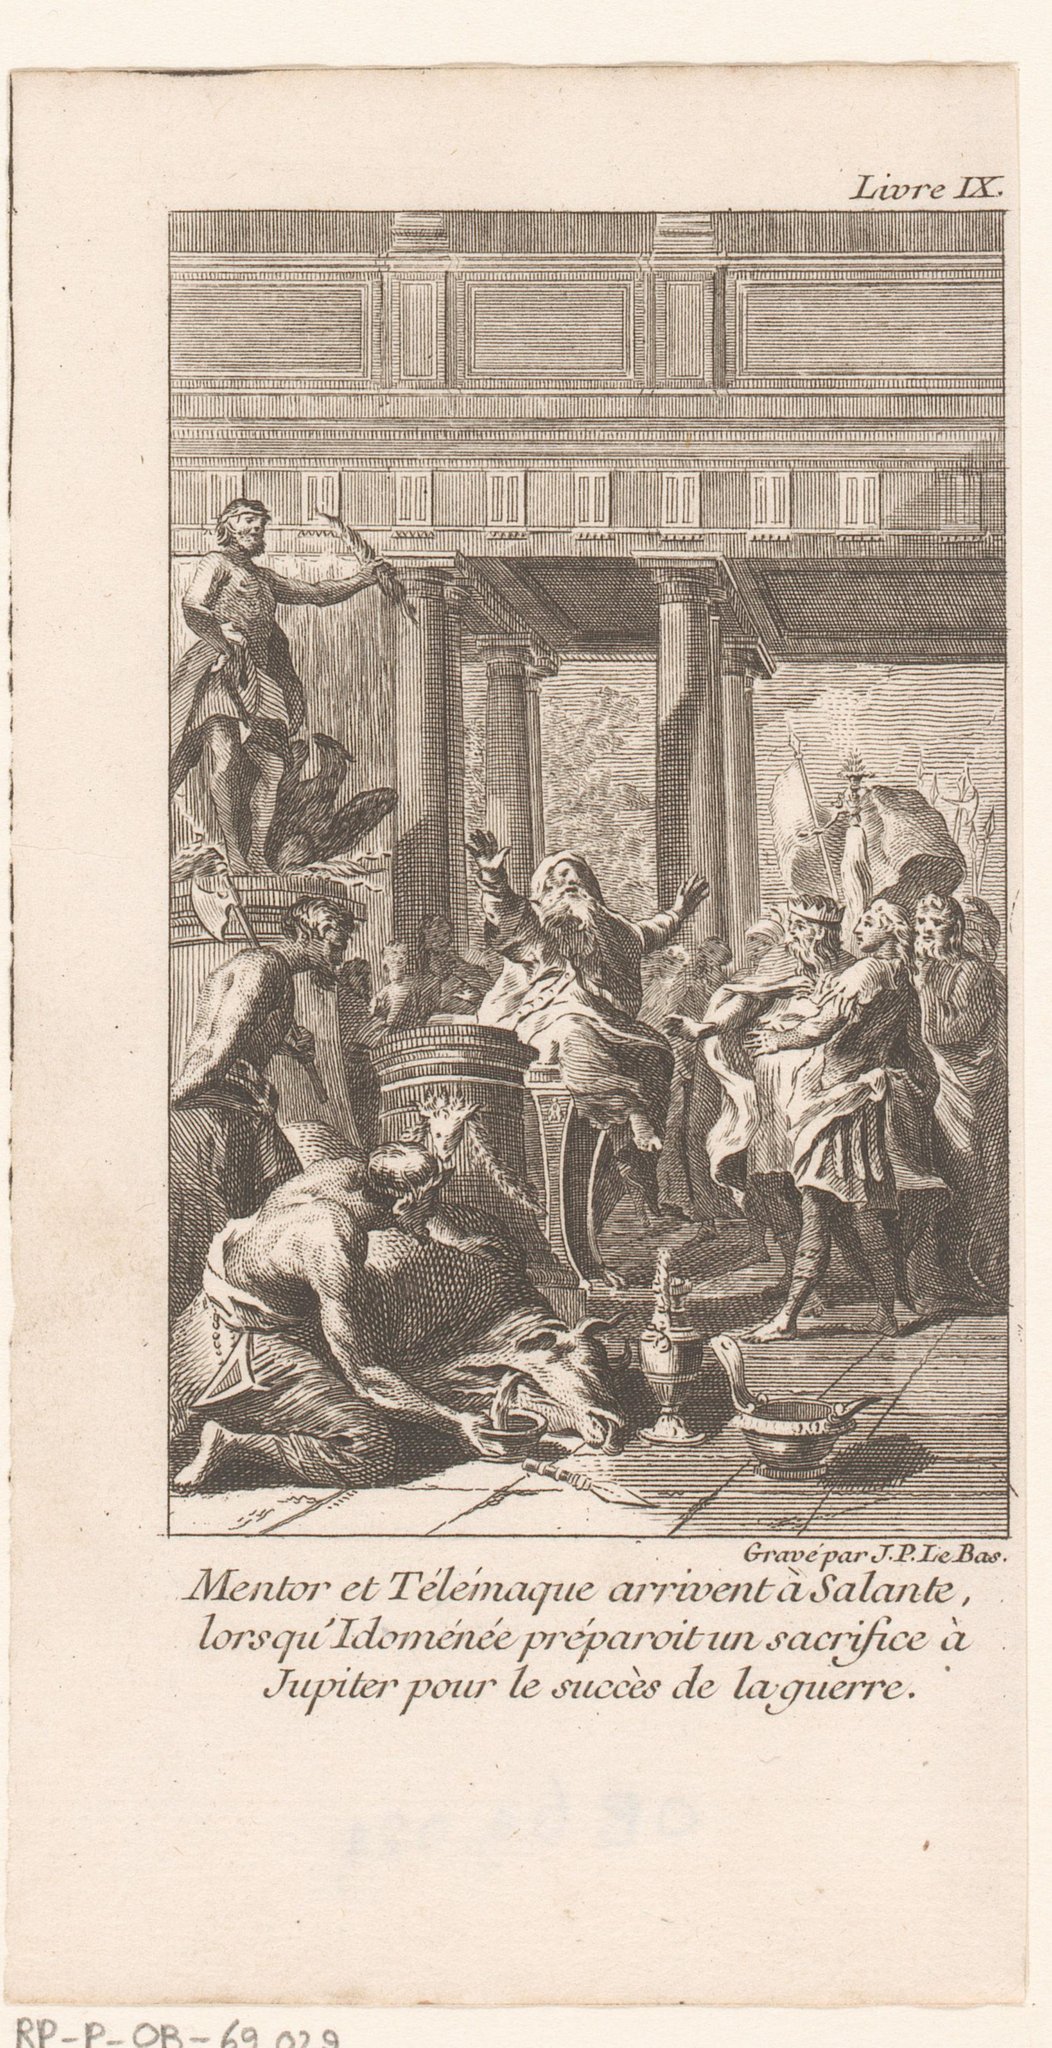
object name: print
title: Mentor en Telemachus arriveren op Salento bij Idomeneus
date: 1755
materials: paper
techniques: etching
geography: paris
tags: (fenelon, telemachus) specific works of literature (with author, title), (story of) telemachus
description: Prent uit: Fénélon, François. Les Aventures de Télémaque. Parijs: Théodore Legras, 1755.